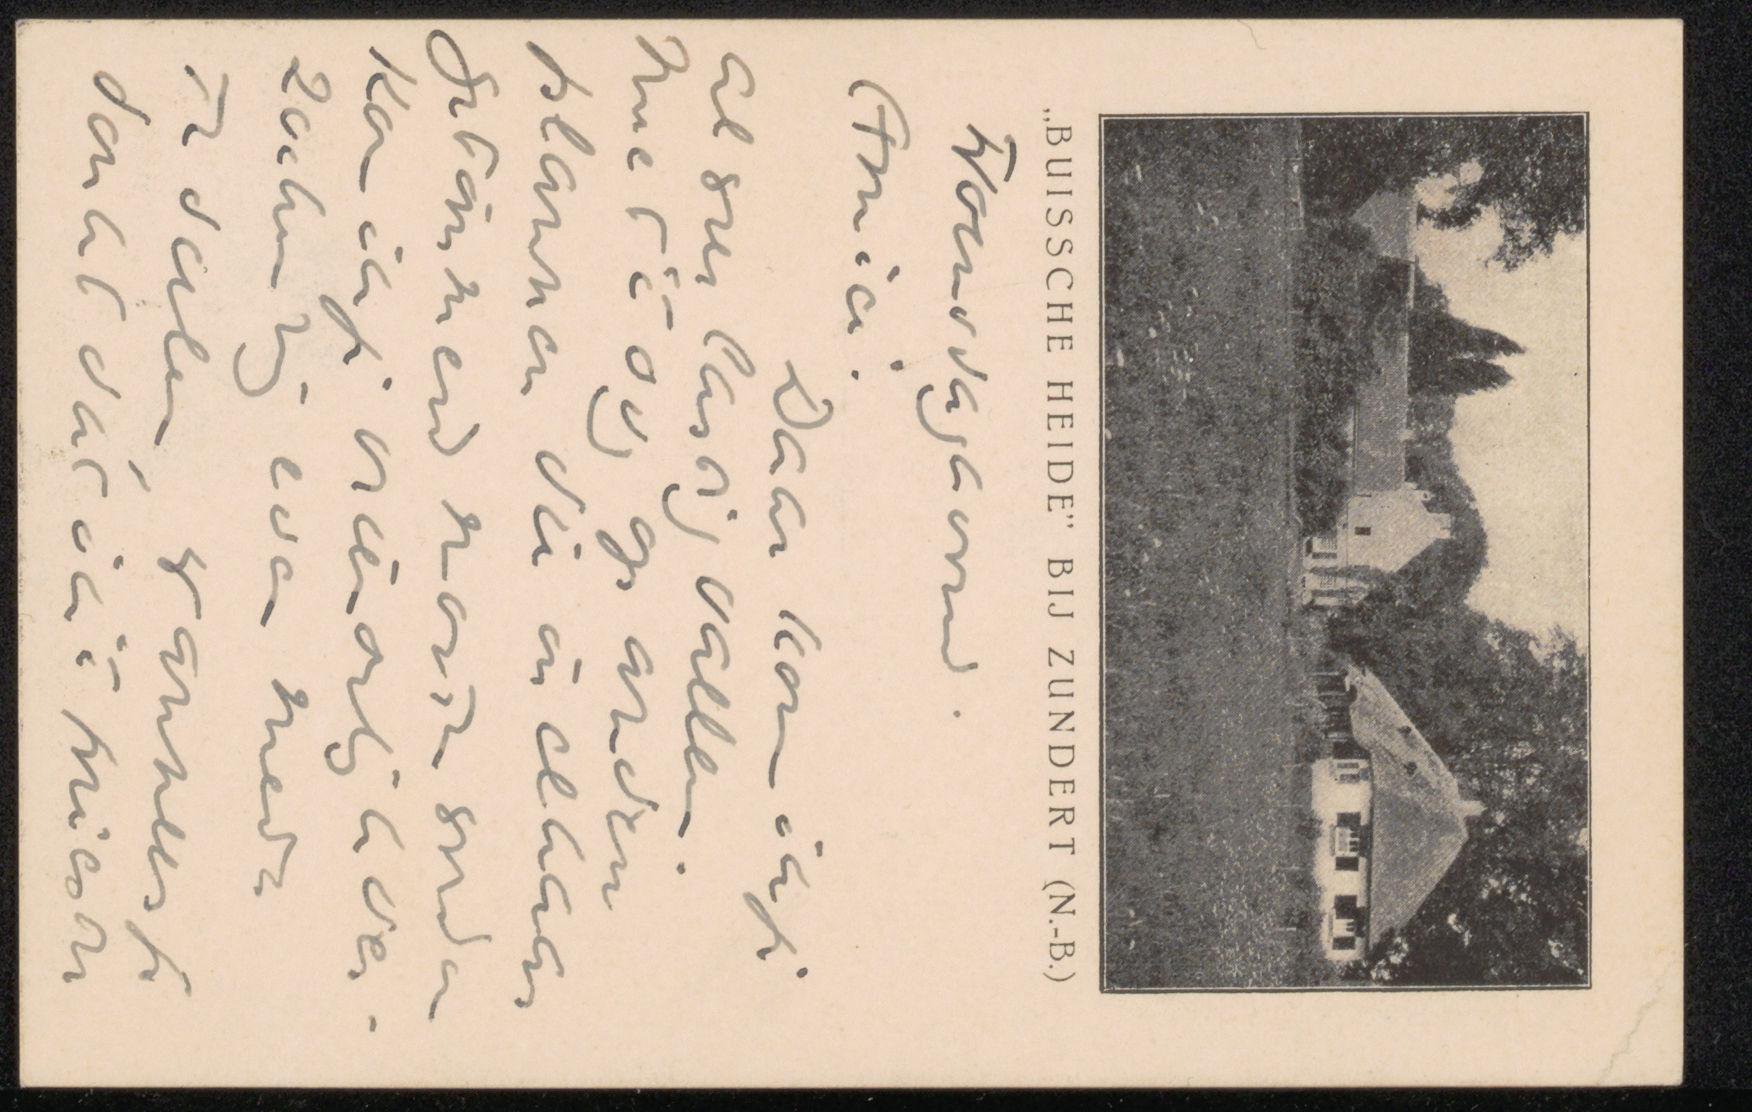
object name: ansichtkaart, prentbriefkaart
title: Prentbriefkaart aan Willem Bogtman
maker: richard nicolaüs roland holst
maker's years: 1868-1938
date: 1935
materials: cardboard, ink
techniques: pen, writing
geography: zundert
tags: willem bogtman, applied arts, arts and crafts; industrial design